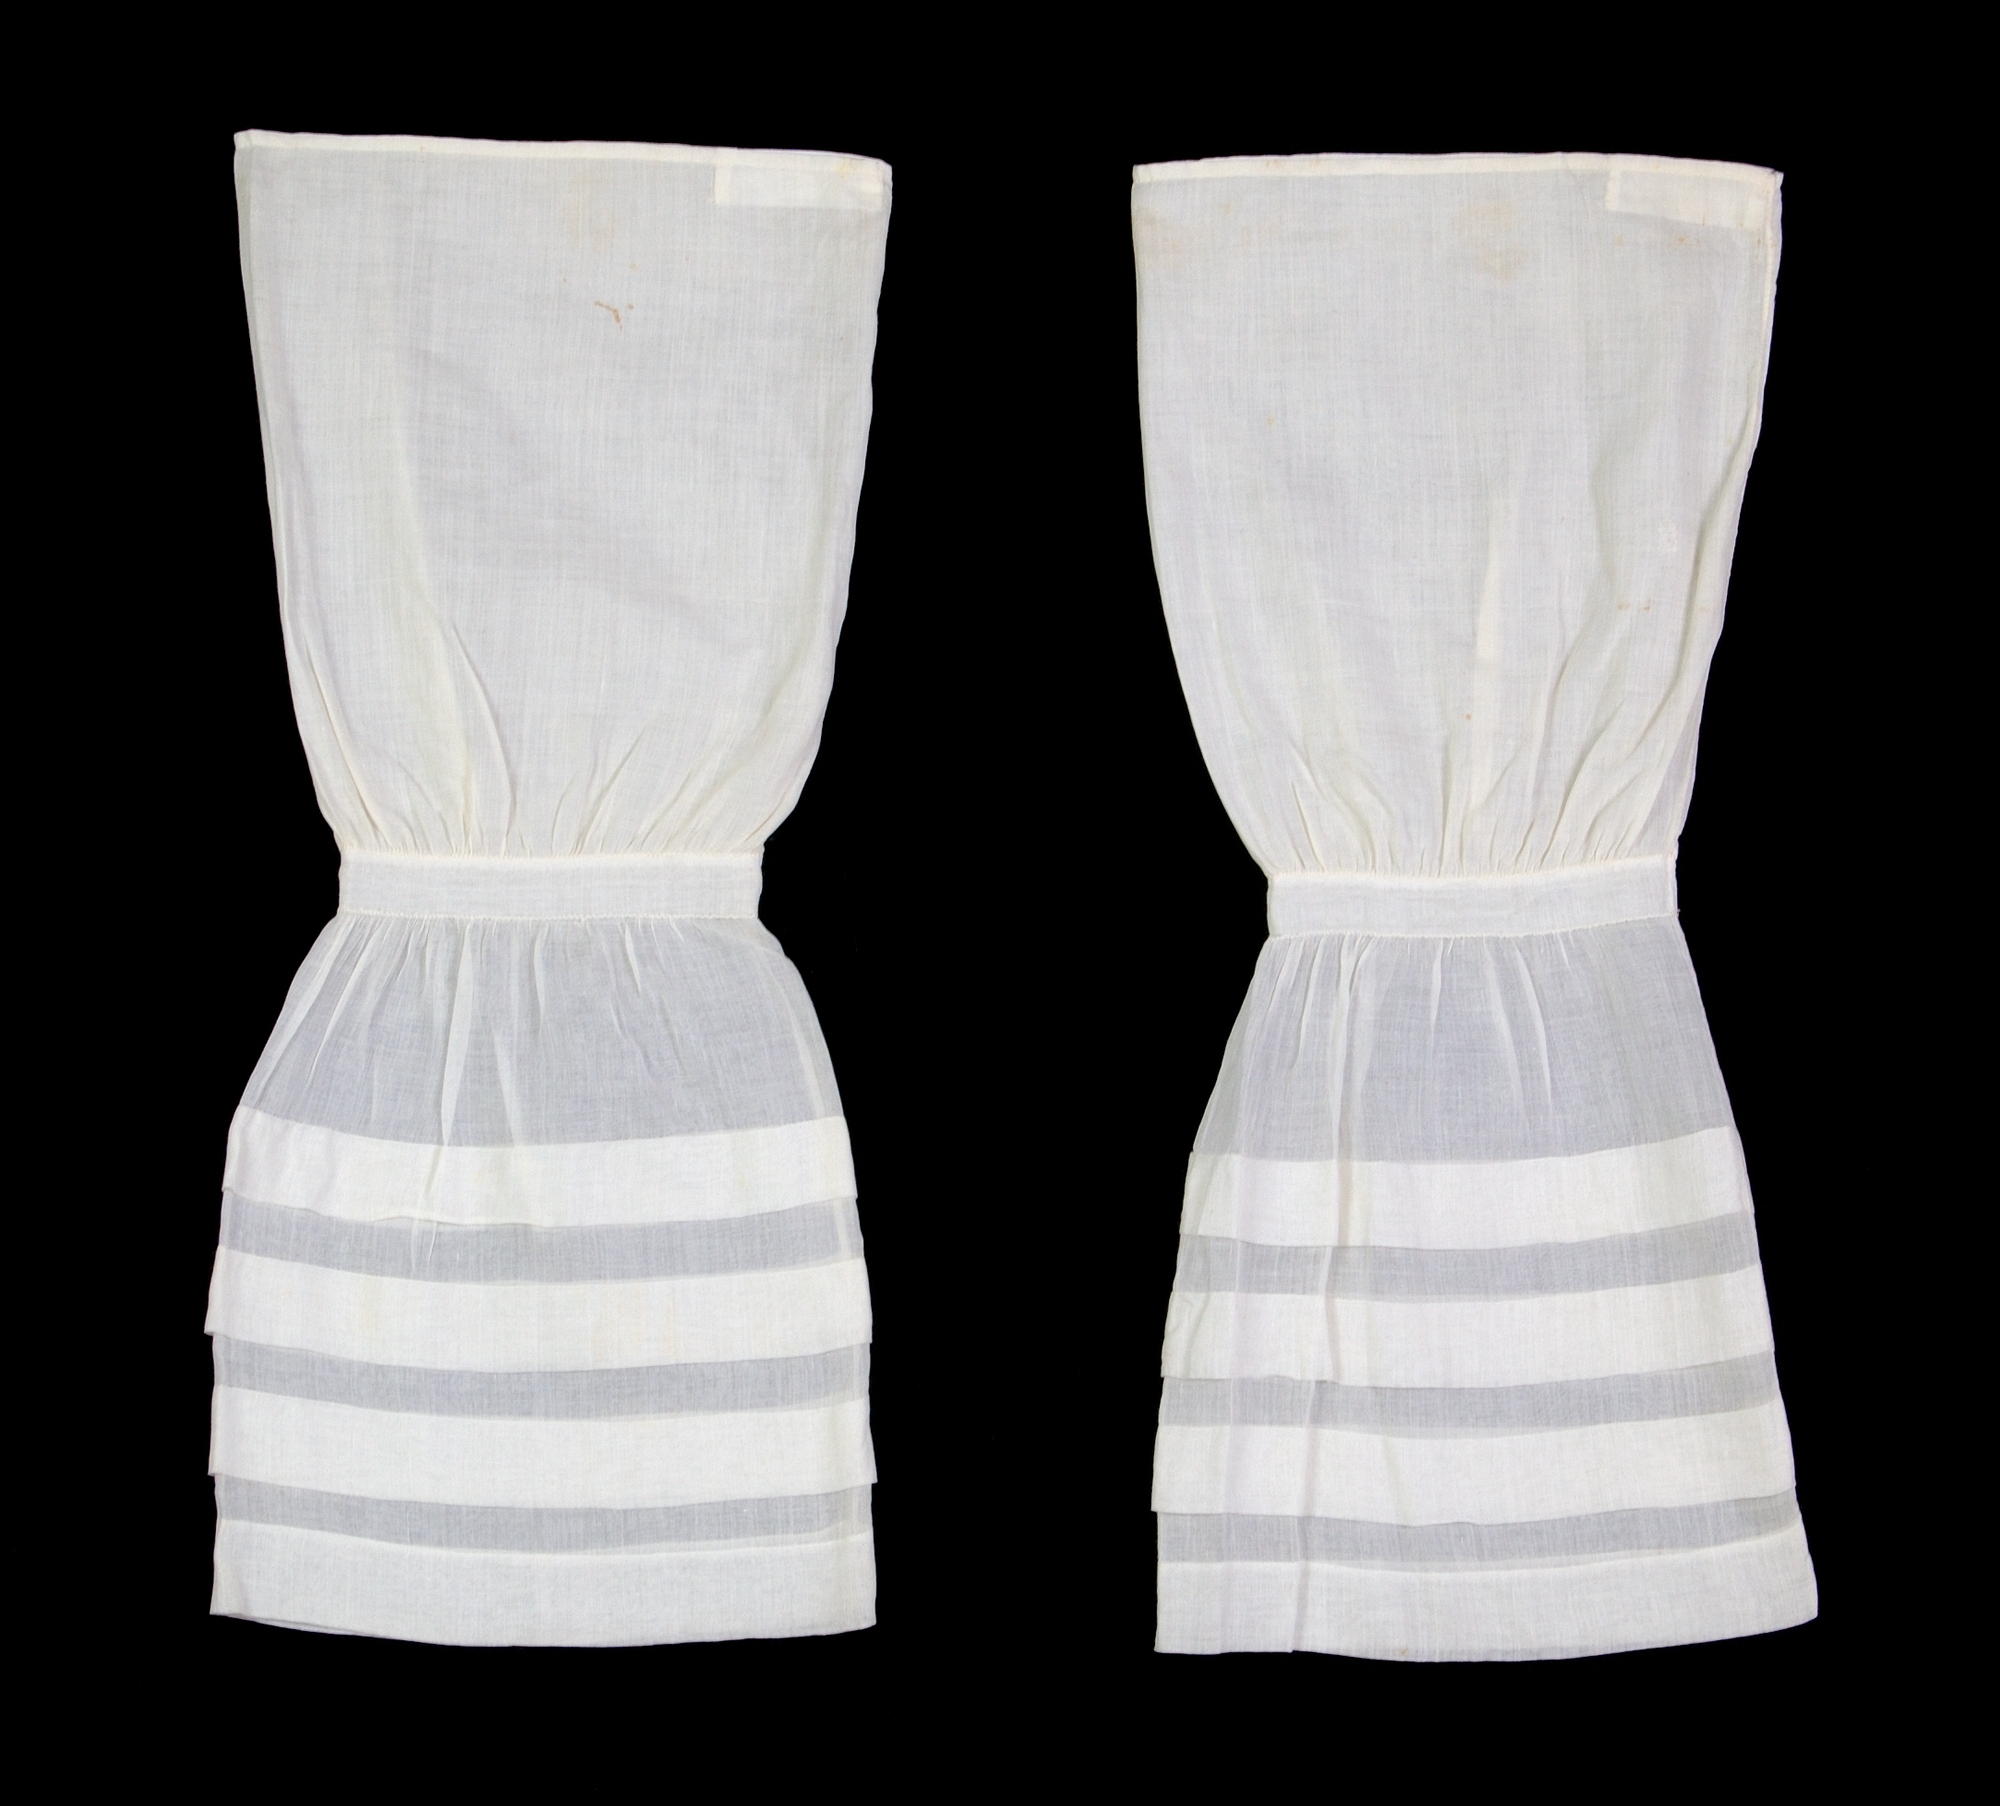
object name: undersleeves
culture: american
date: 1855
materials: cotton